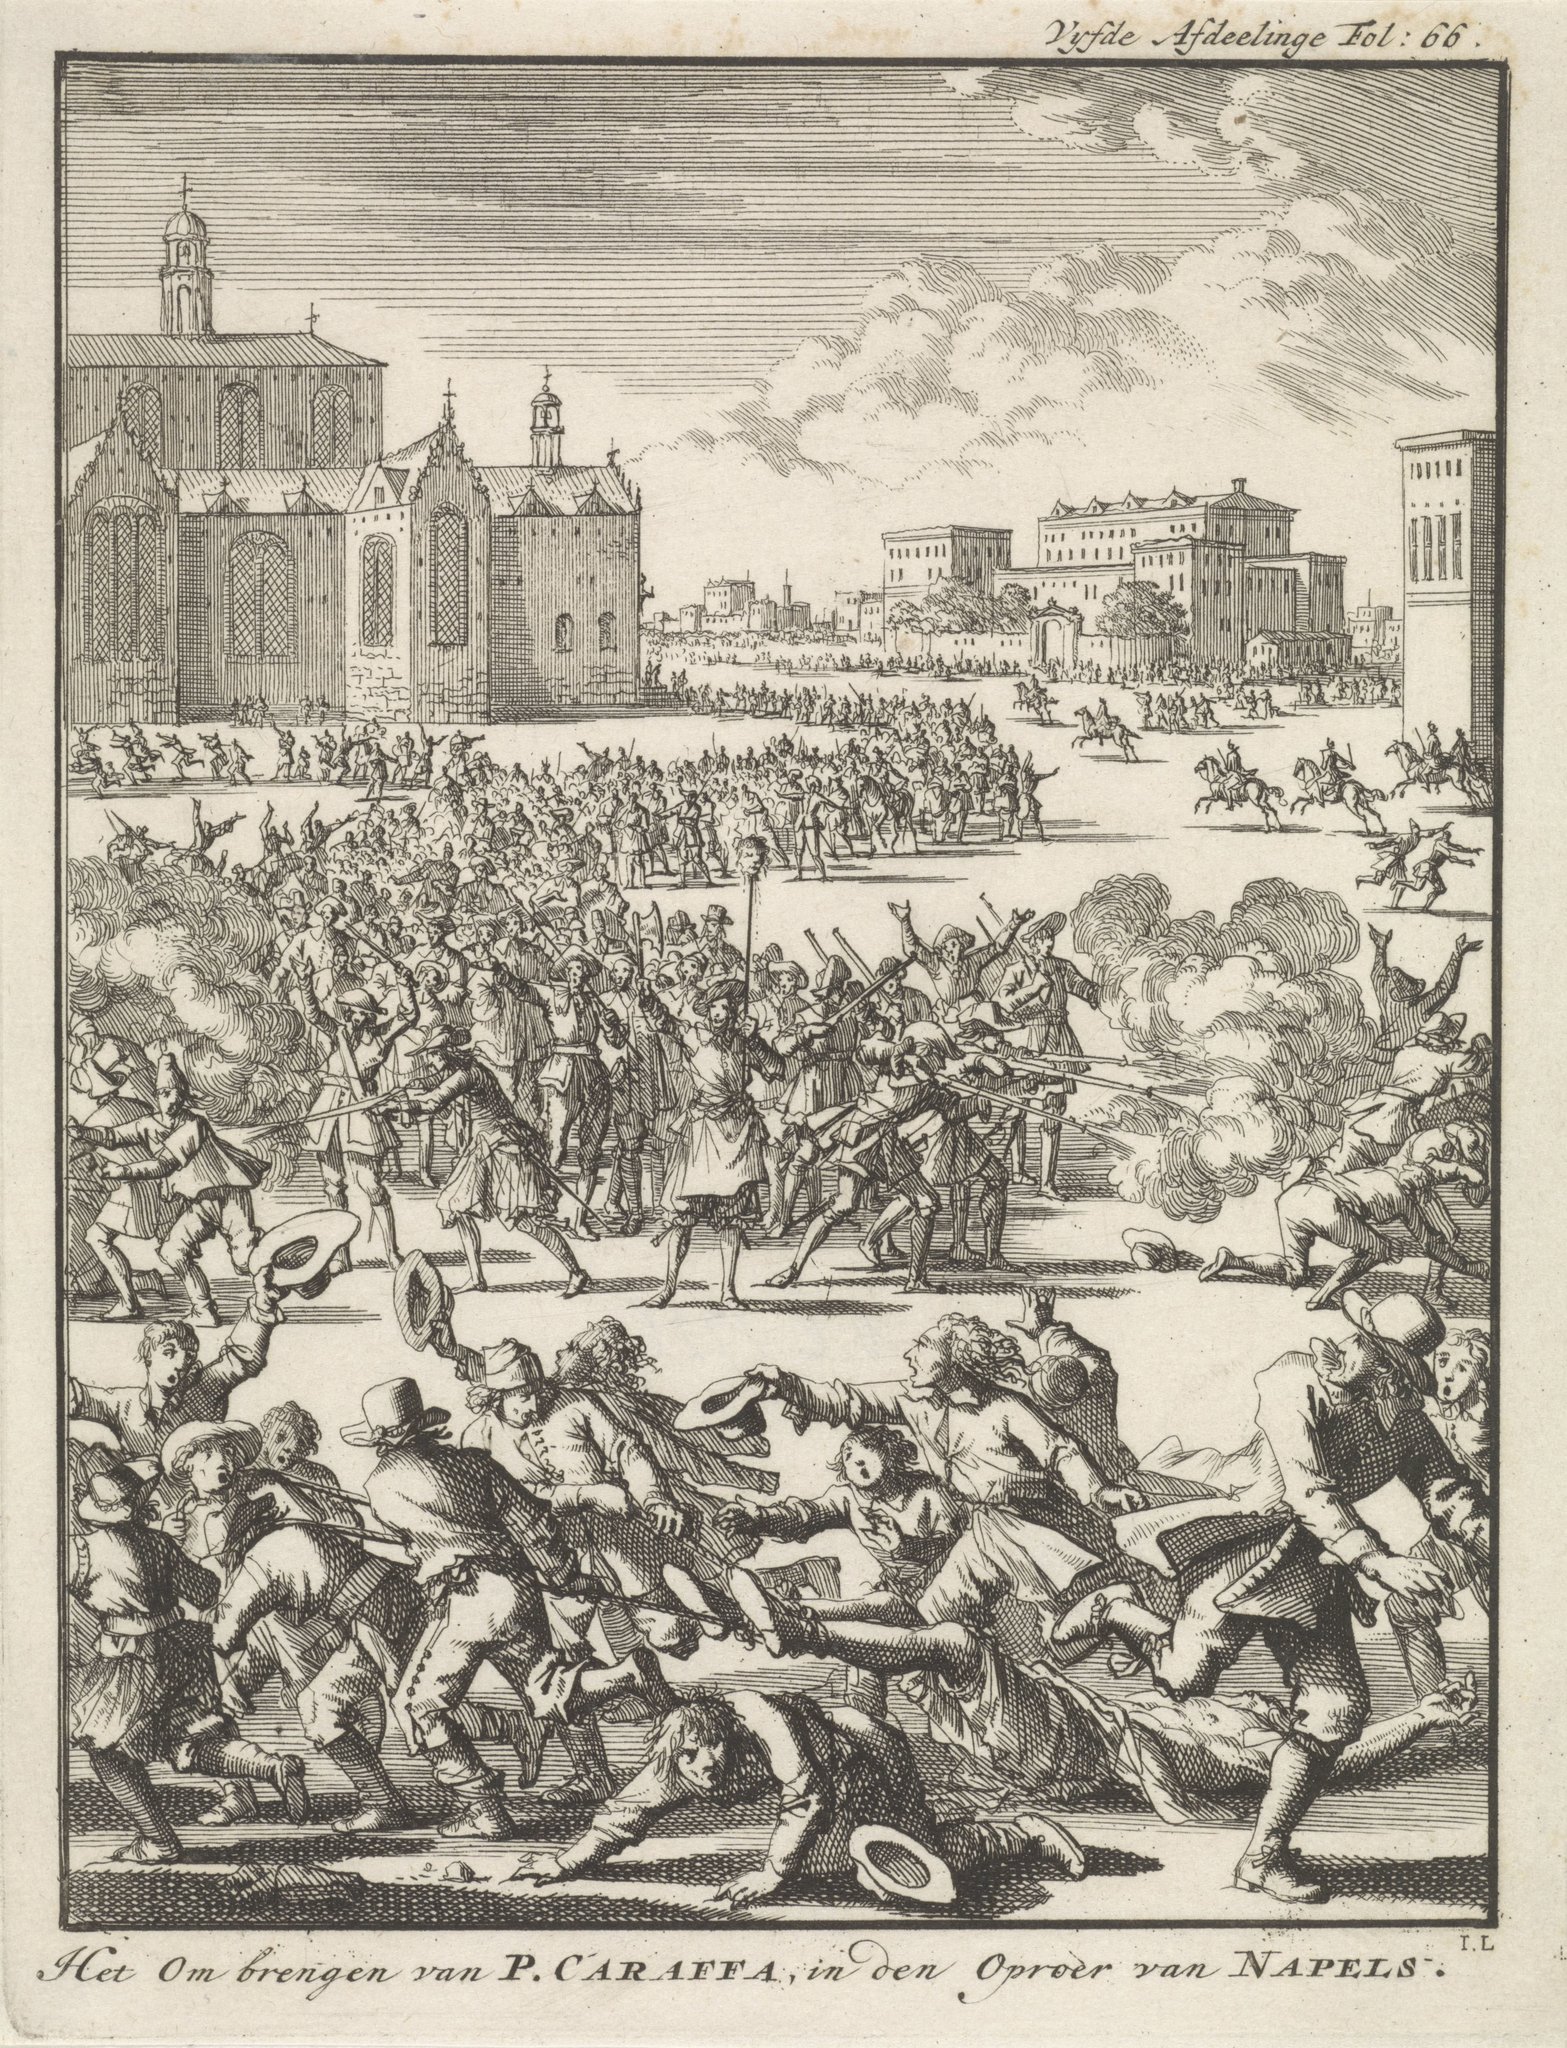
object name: book illustration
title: Giuseppe Caraffa omgebracht tijdens een oproer in Napels, 1647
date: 1698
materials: paper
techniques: etching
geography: amsterdam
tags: naples, street-fights, riots, murderer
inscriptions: collector's mark: Lugt 2228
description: Illustratie uit: Bos, Lambert van den. Treur-toonneel der doorluchtige mannen, of Op- en ondergang der grooten, 3 delen. Amsterdam: Jan Claesz ten Hoorn, 1698, dl. III.